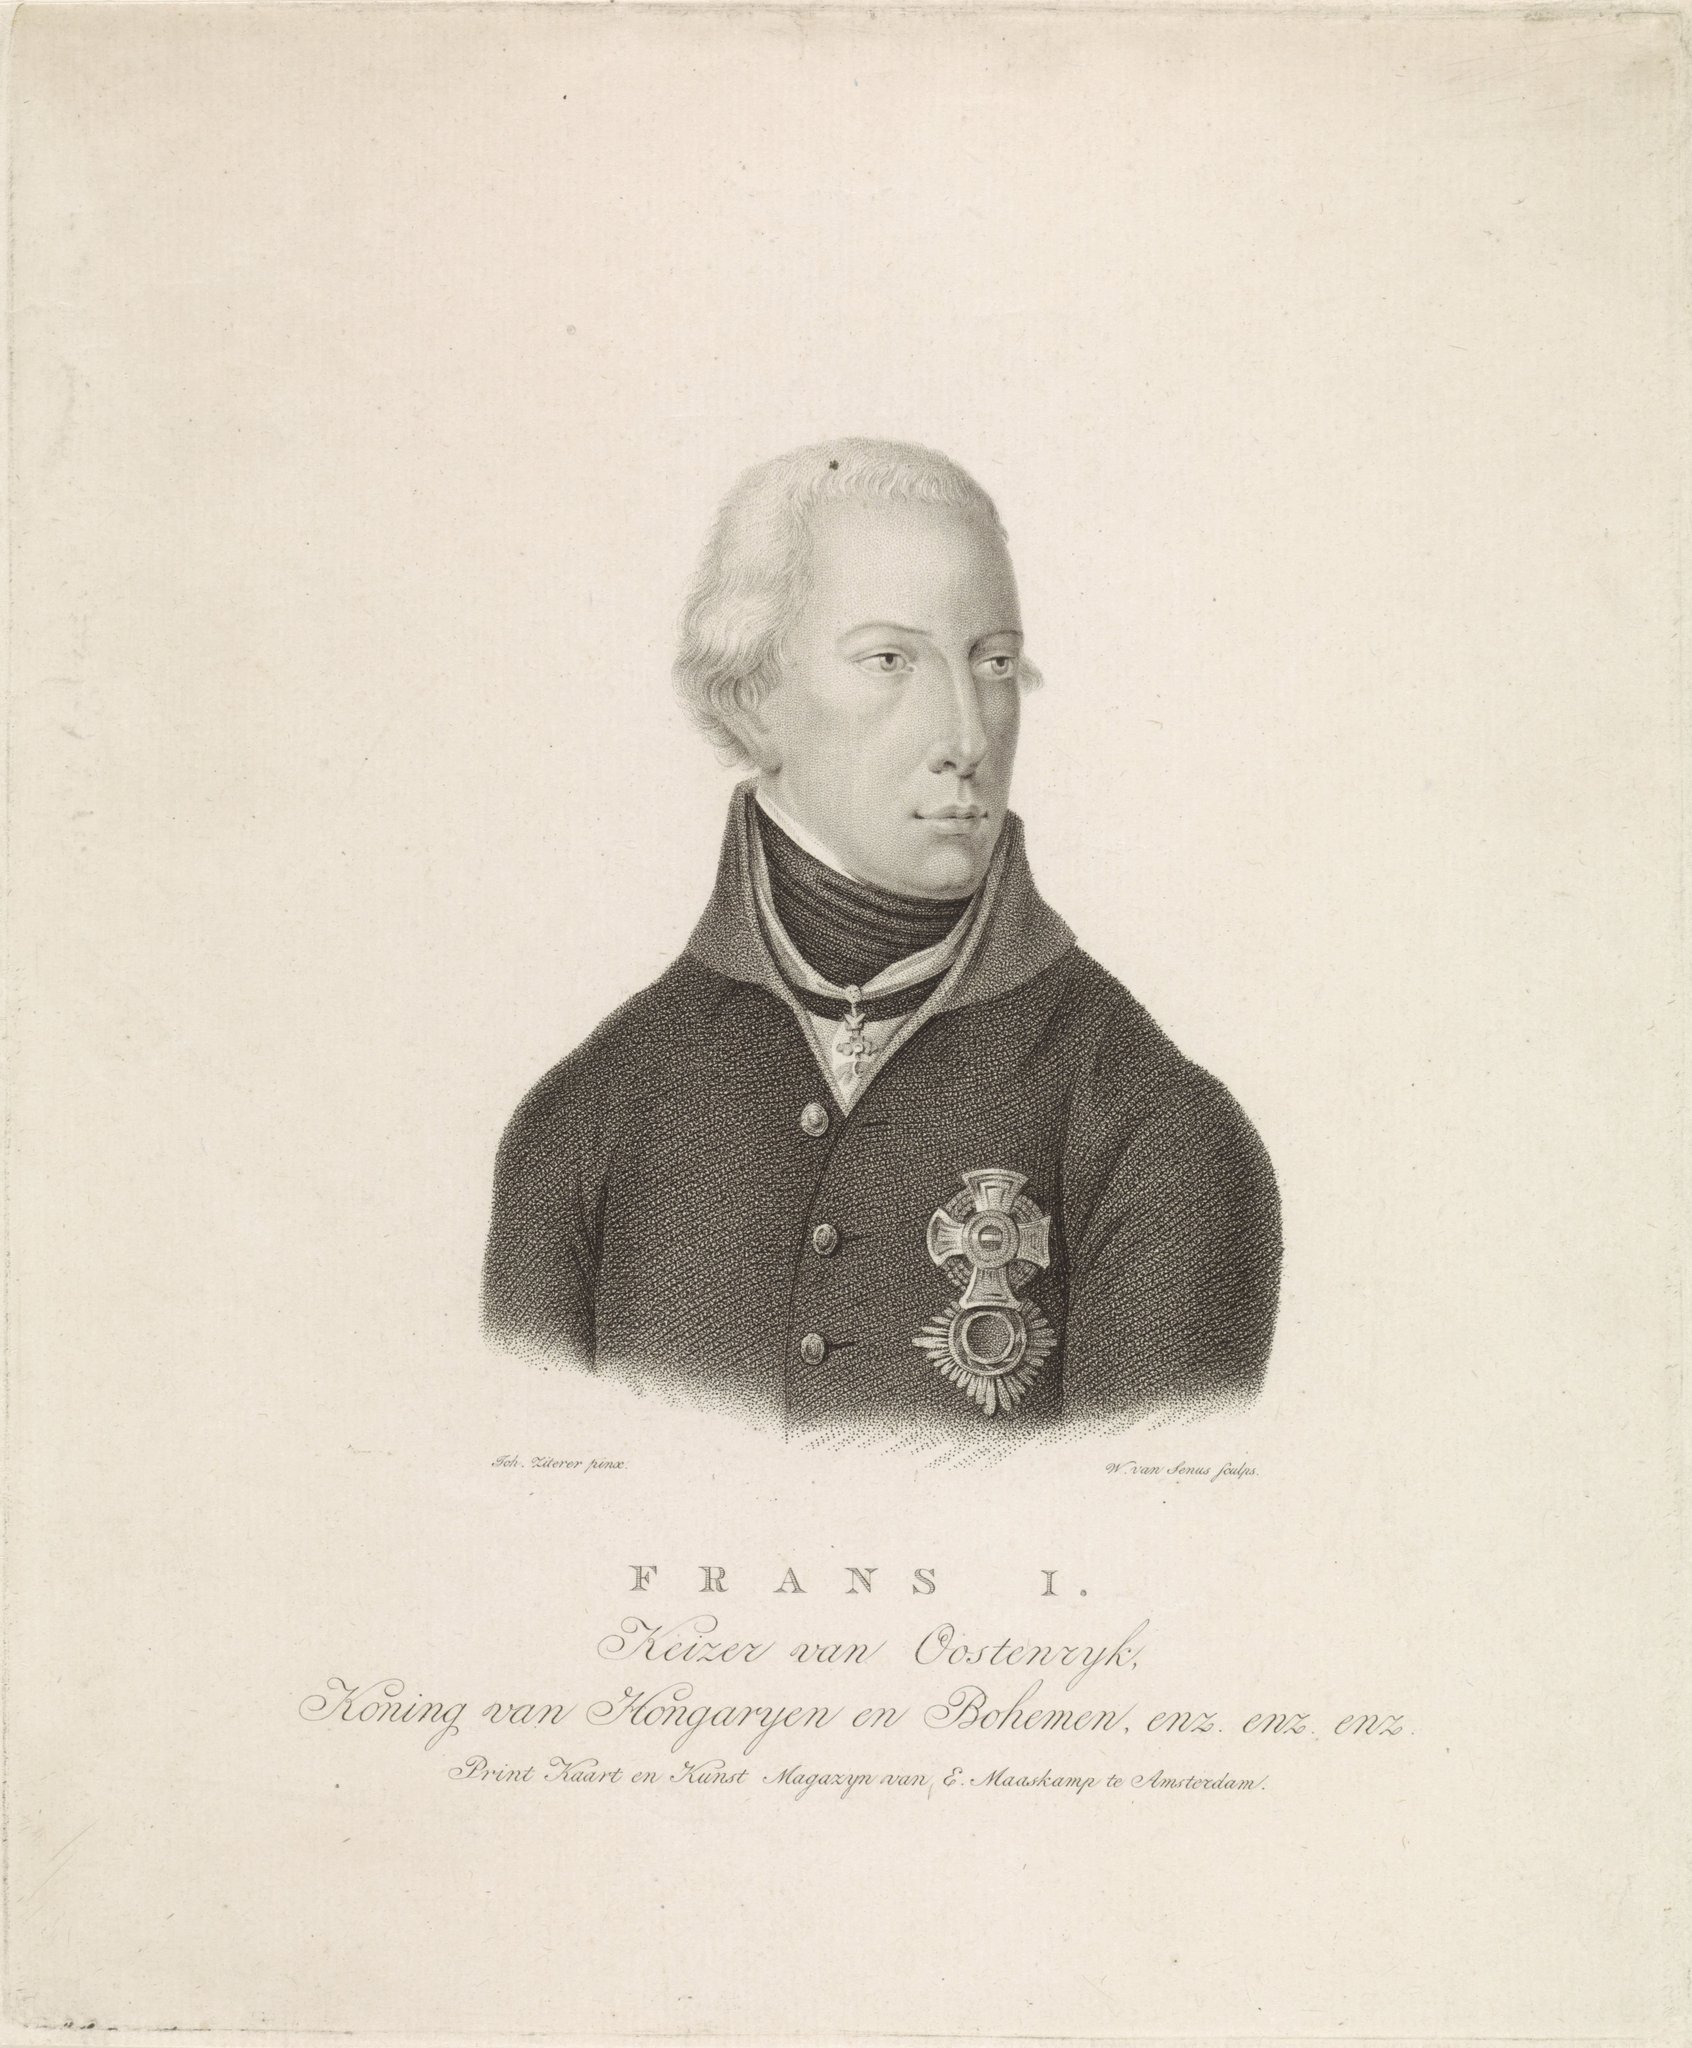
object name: print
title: Portret van Frans II Josef Karel (Rooms-Duits keizer)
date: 1804-1851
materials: paper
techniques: engraving, etching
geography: amsterdam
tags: vienna, frans ii (rooms-duits keizer)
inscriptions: collector's mark: Lugt 2228